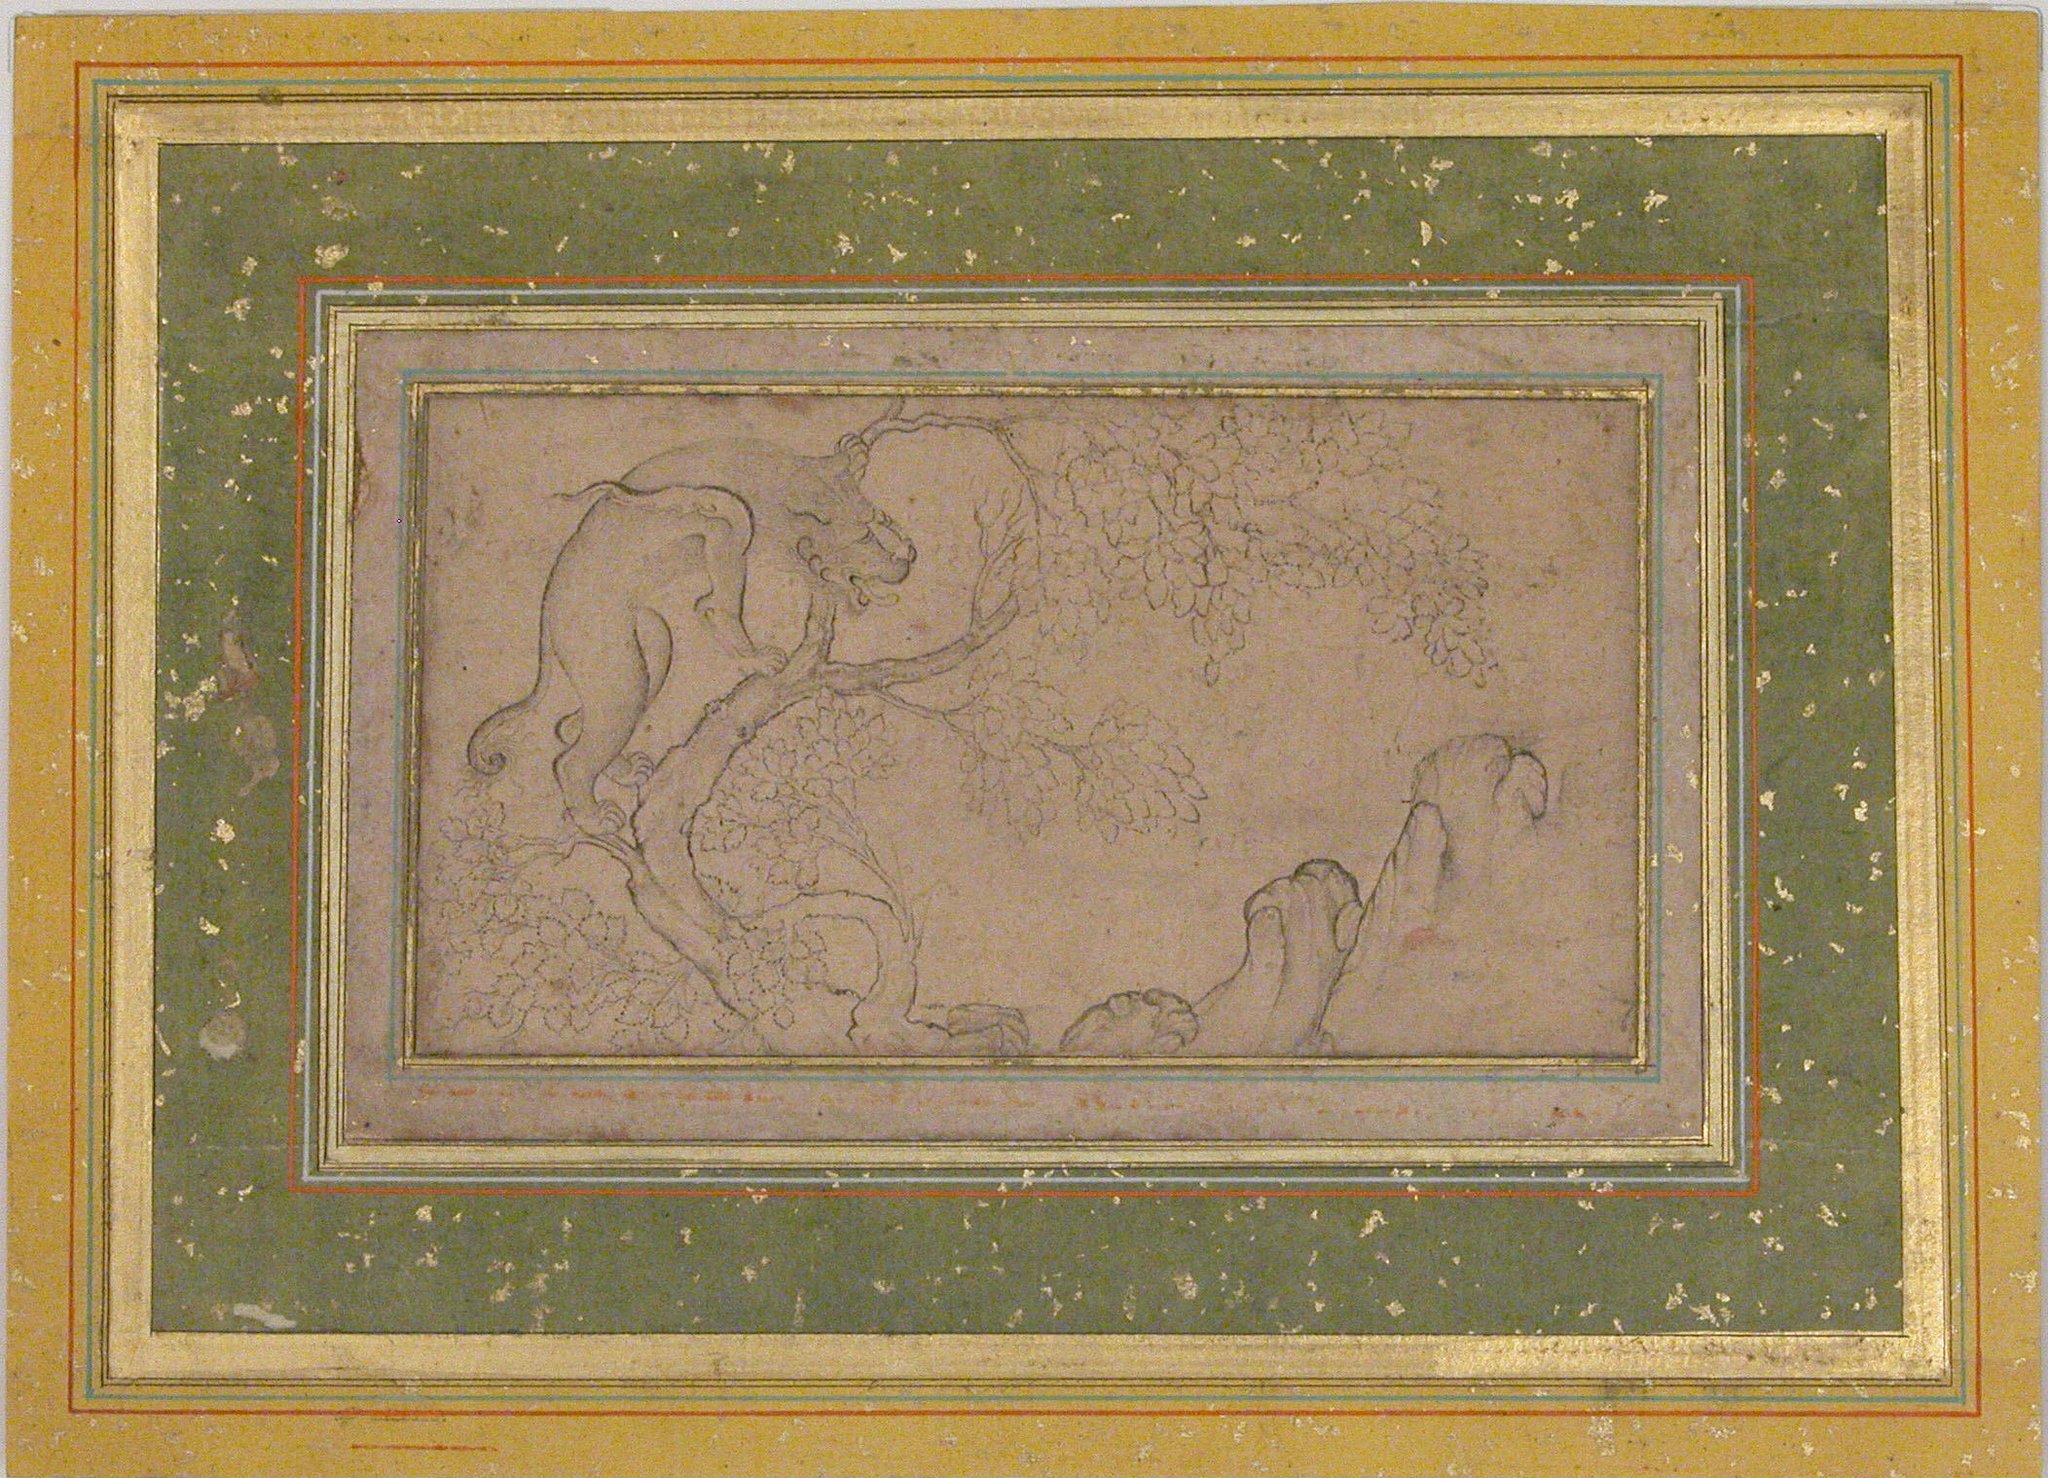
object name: illustrated single work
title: Lion (Chi'lin) in a Landscape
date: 1567-1600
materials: gold, ink, paper, watercolor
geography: iran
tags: lions,landscapes,trees